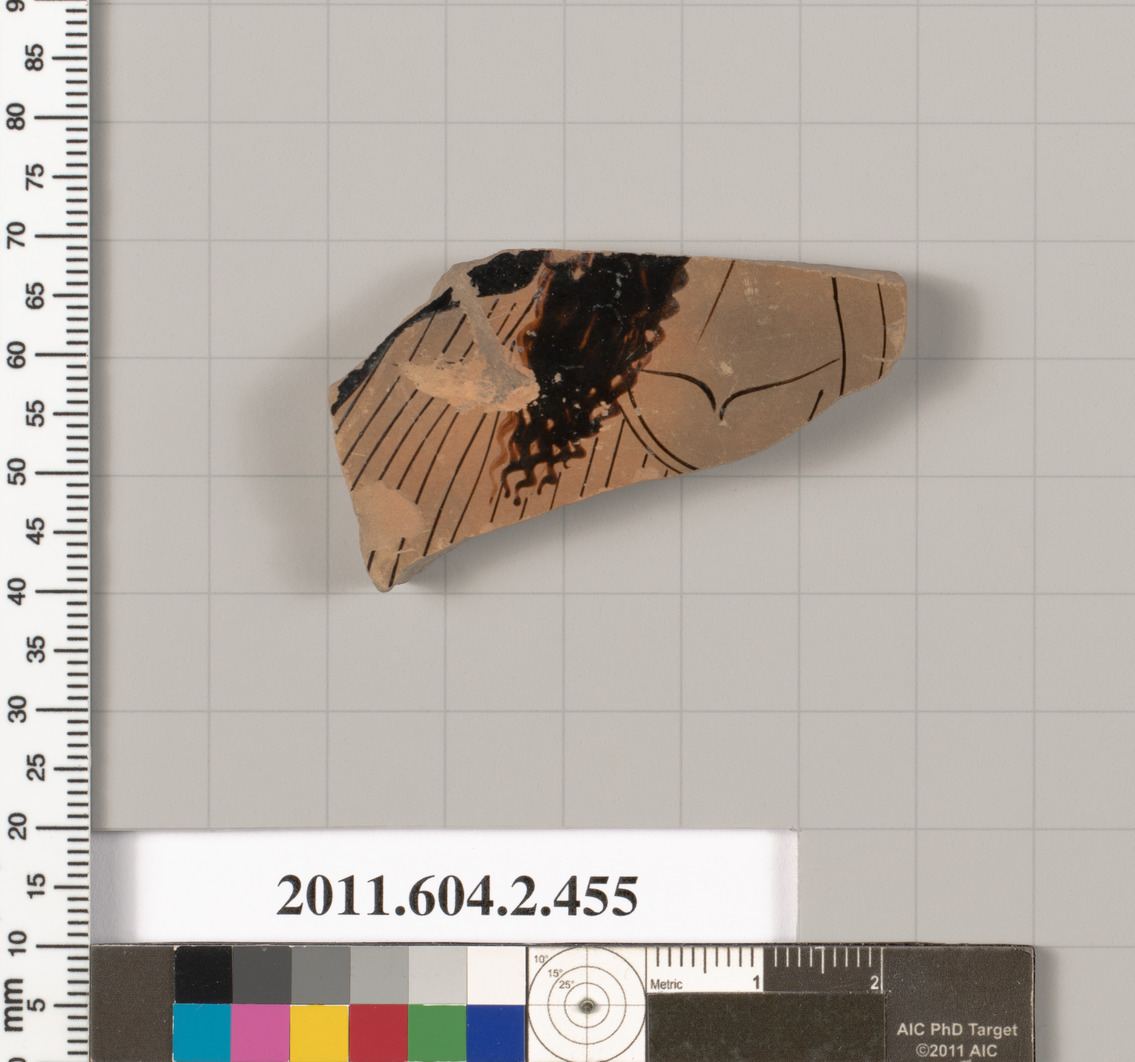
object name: column krater fragment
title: Terracotta fragment of a column-krater (bowl for mixing wine and water)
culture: greek, attic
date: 470-450 BCE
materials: terracotta